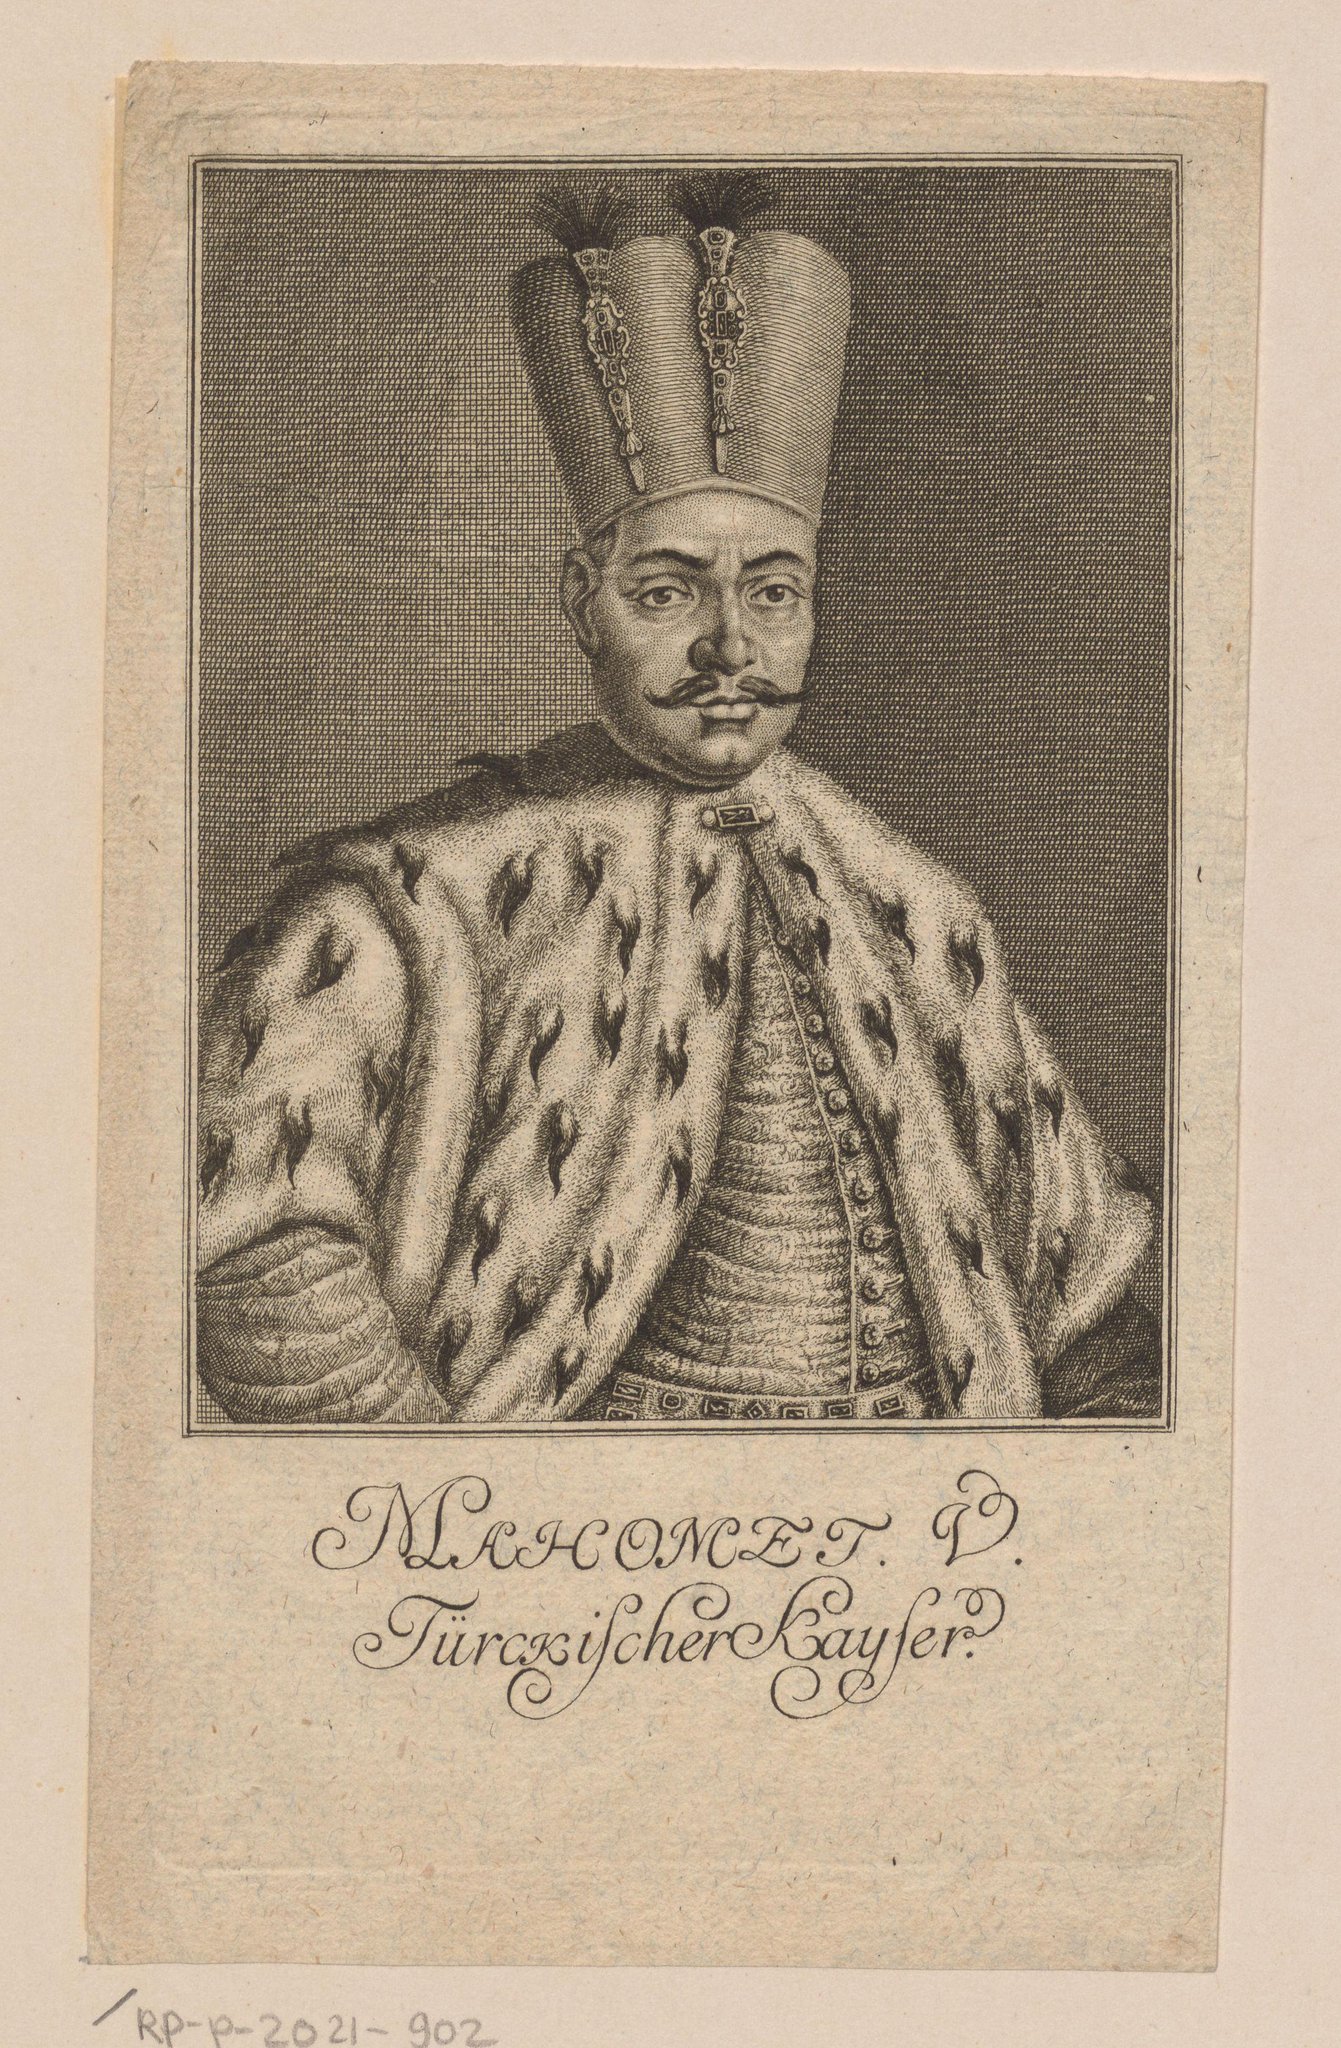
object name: print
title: Portret van Mahmut I, sultan van het Ottomaanse Rijk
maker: Anonymous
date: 1730-1754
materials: paper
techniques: engraving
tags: politician, historical persons, head-gear: turban, ruler, sovereign